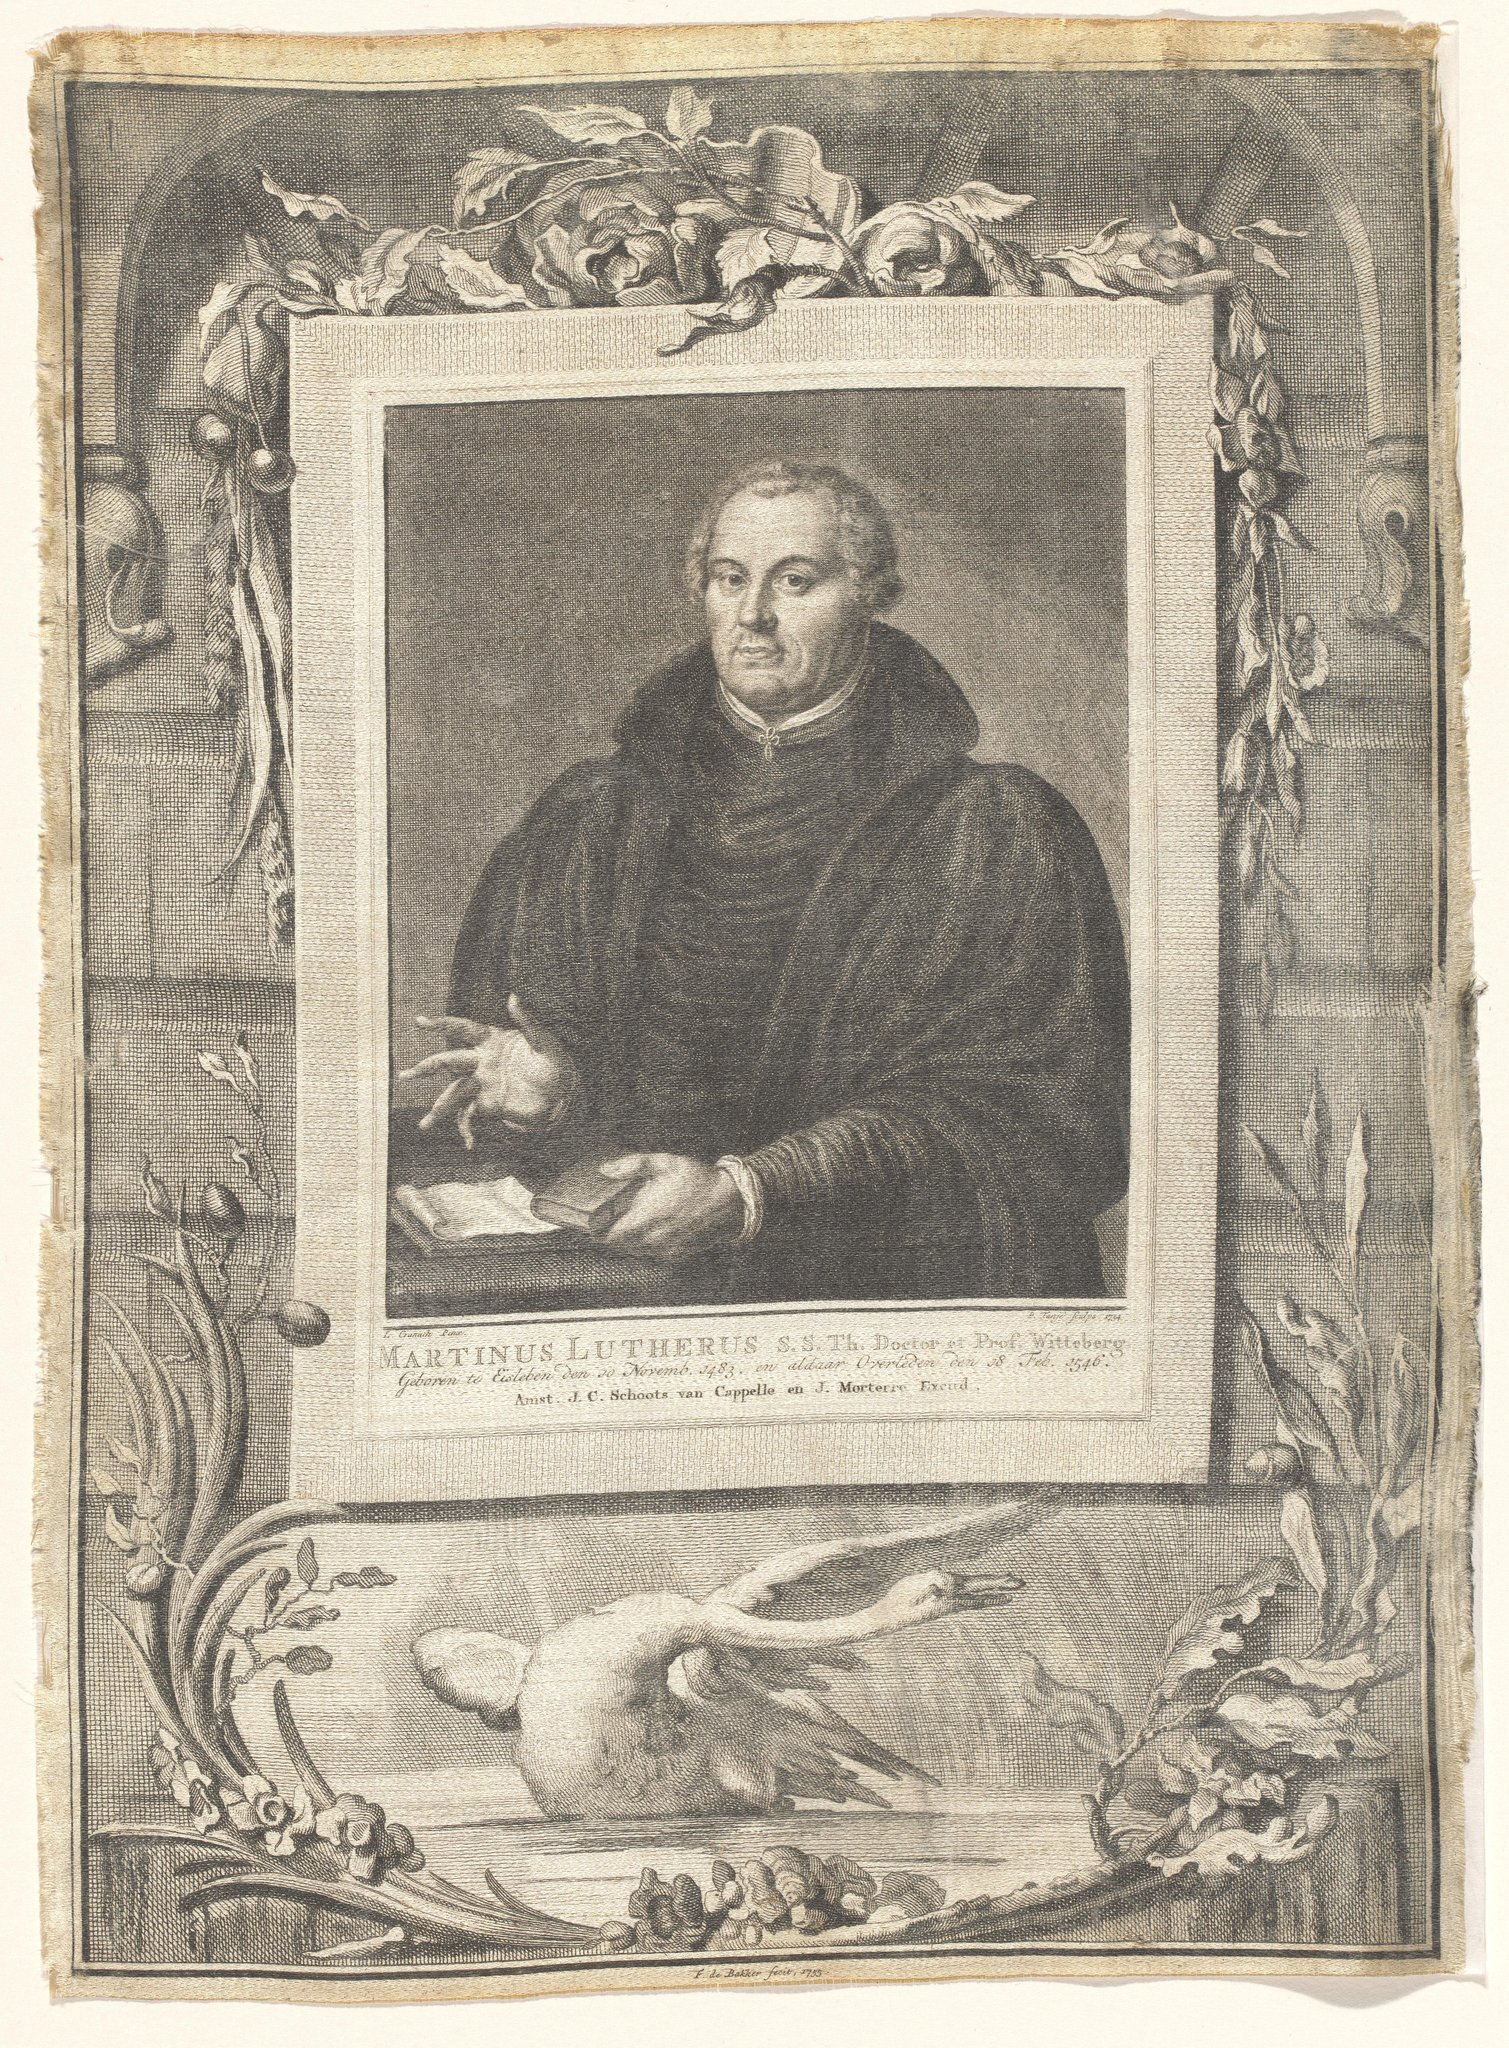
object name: print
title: Portret van Maarten Luther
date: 1754-1755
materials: silk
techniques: engraving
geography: amsterdam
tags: priest, martin luther, water-birds: swan, historical persons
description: Portret van Maarten Luther, staand bij een tafel, met een Bijbel in zijn hand. Rond het portret guirlandes van bloemen en planten. Onderaan de zwaan als symbool van Luther. Op zijde gedrukt.